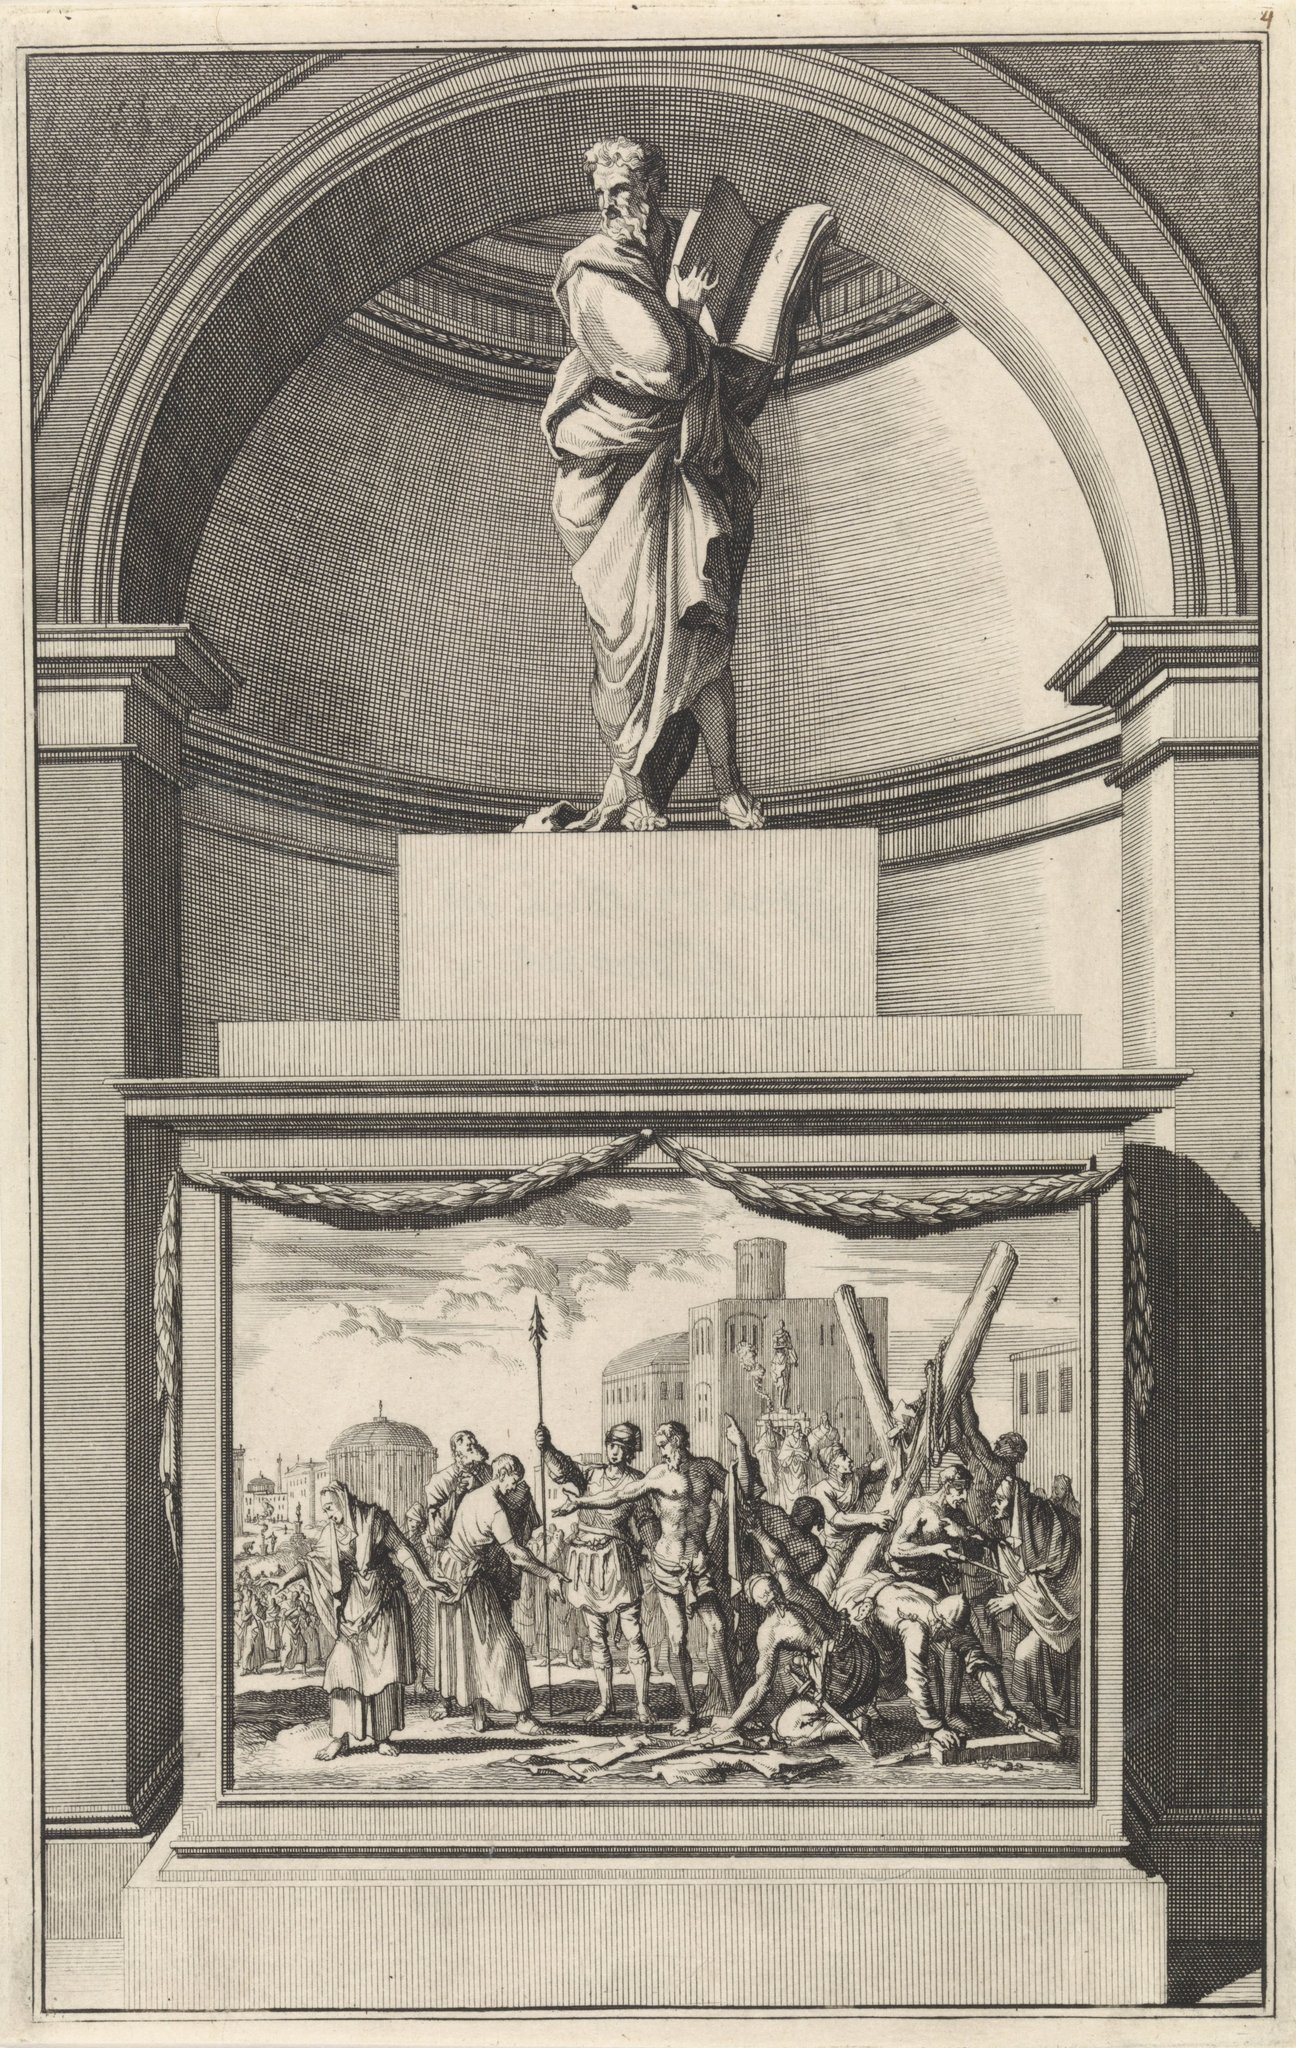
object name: print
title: Apostel Bartolomeüs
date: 1698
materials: paper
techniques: engraving, etching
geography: amsterdam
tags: the apostle bartholomew; possible attributes: book, devil or dragon at feet, knife, scroll, flayed skin, staff, bartholomew flayed alive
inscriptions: collector's mark: Lugt 2228, number: ‘4’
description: Proefdruk van illustratie uit: Cave, William. Apostolische oudheden, of Het leven (...) der heylige apostelen, 3 delen. Utrecht: François Halma en Willem van de Water (I), 1698, p. 311.